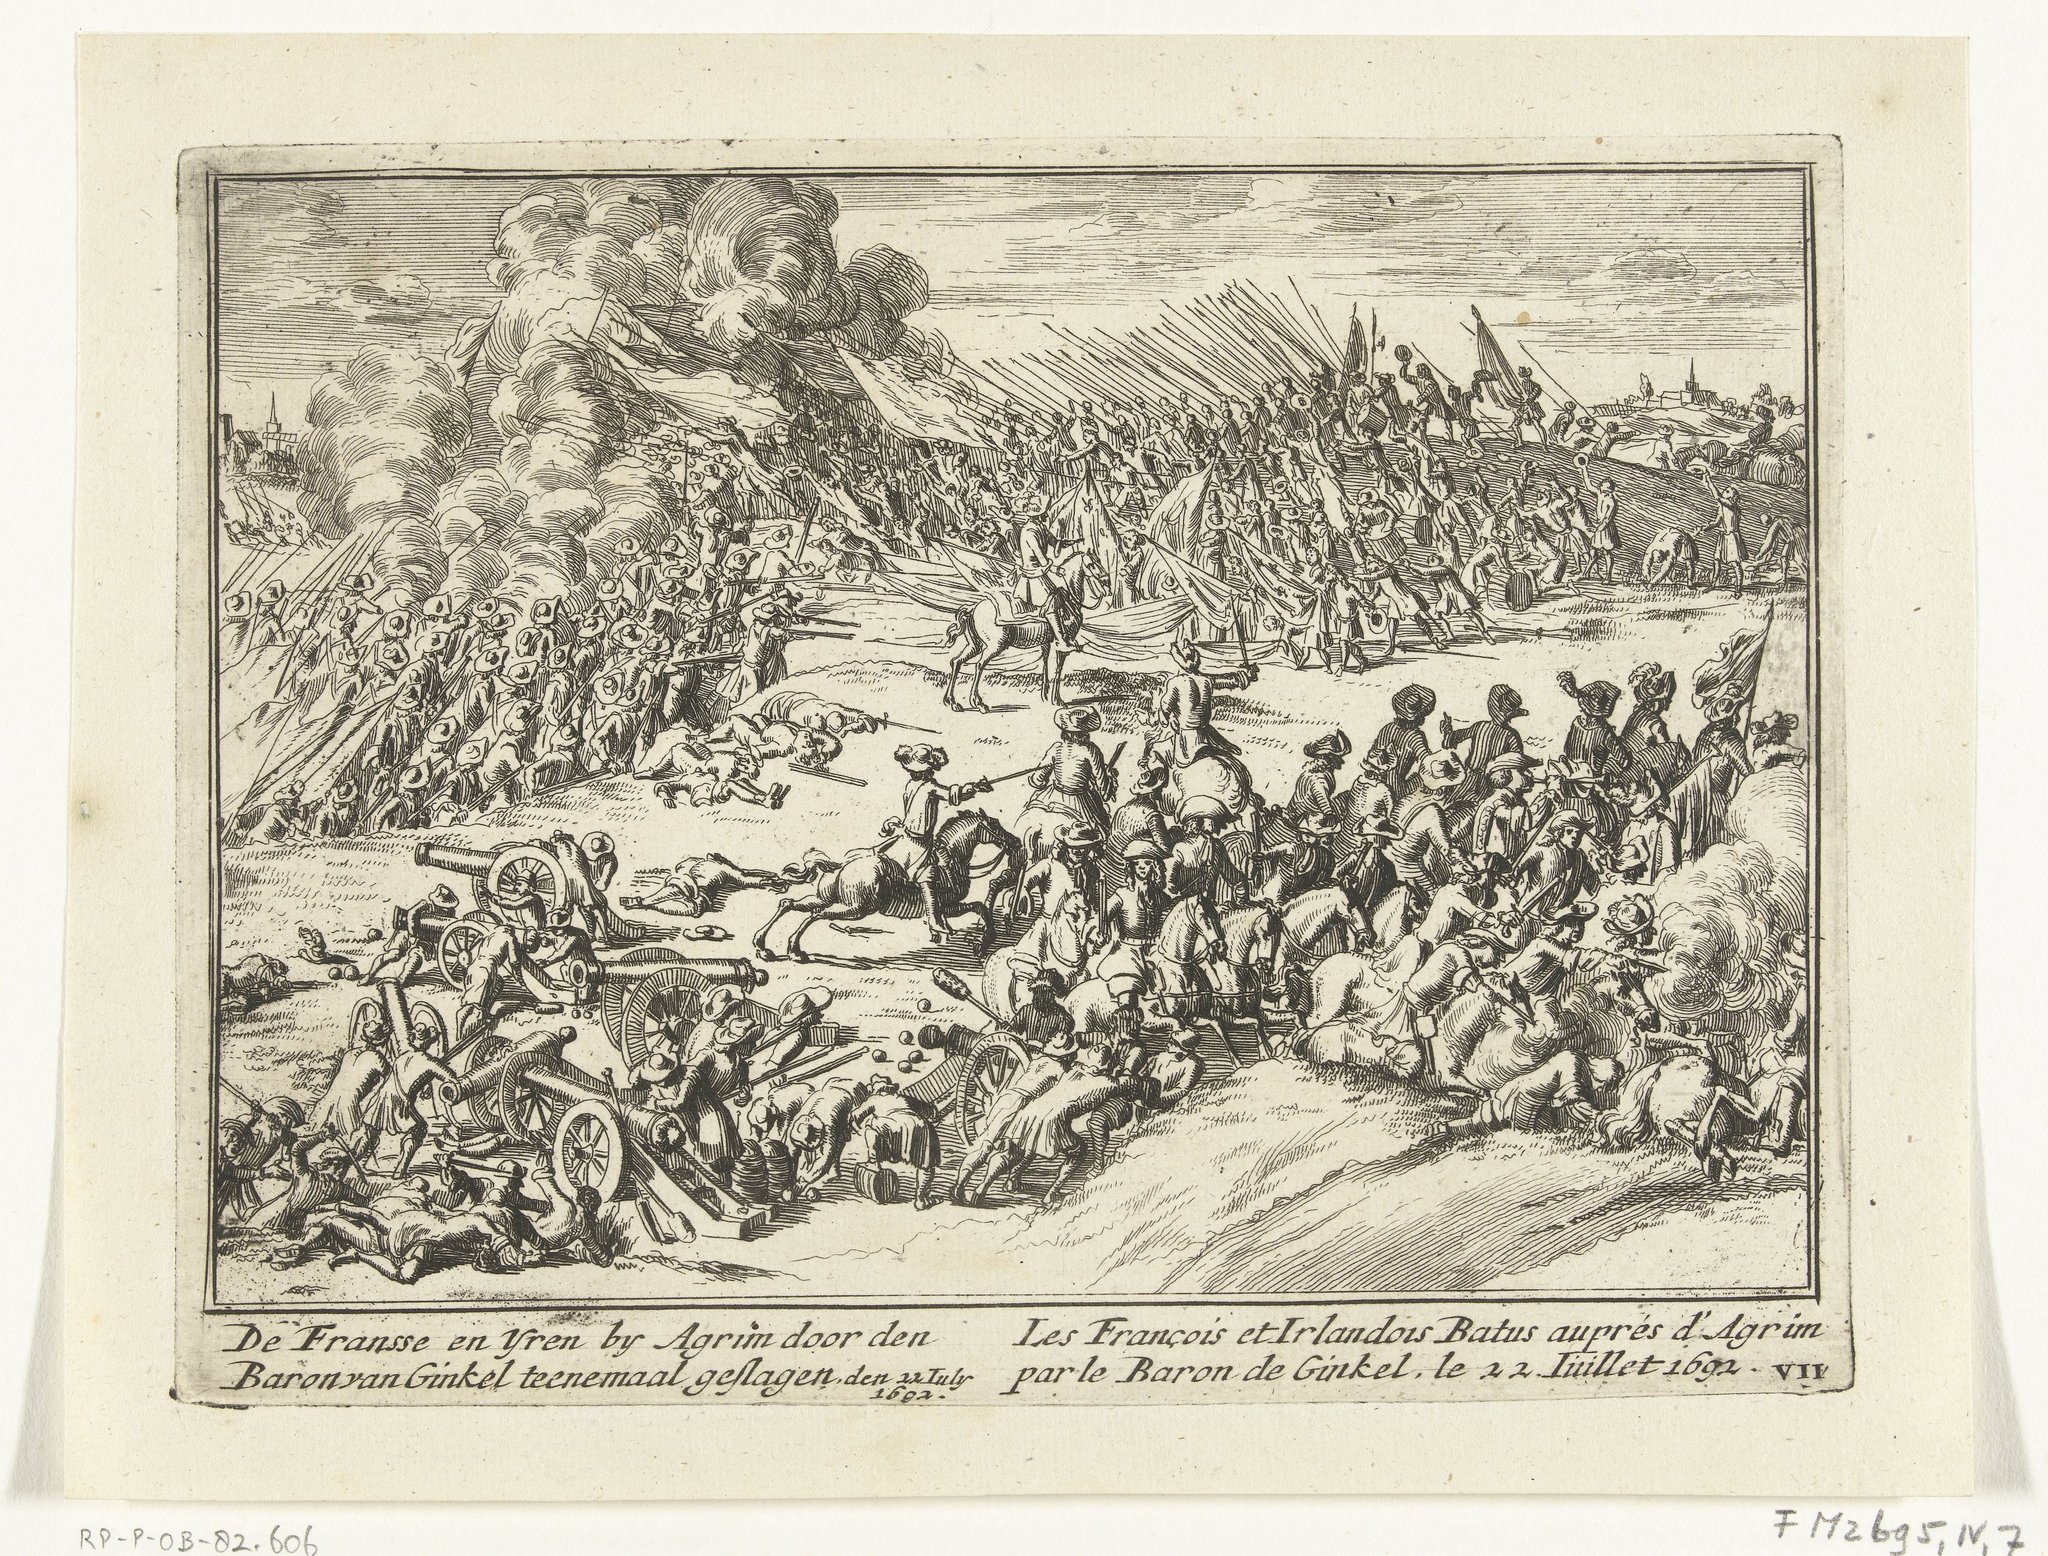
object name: print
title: De Franse en Yren by Agrim door den Baron van Ginkel teenemaal geslagen, den 22 July 1692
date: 1695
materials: paper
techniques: etching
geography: northern netherlands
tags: utrecht, godard baron van reede-ginckel (graaf van athlone), battle (+ land forces)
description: Beslissende overwinning behaald door het Engelse leger van koning Willem III onder de Nederlandse generaal Godard baron de Ginckel op de katholieken van Jacobus II en Fransen, bij Aughrim (of Aghrim) op 22 juli 1691. Plaat nr. VII in de serie 'Engelands schouwtoneel' over oorlogen gevoerd door Willem III in de jaren 1691-1695 na de Glorious Revolution, (vierde deel). Met onderschriften in het Nederlands en Frans.